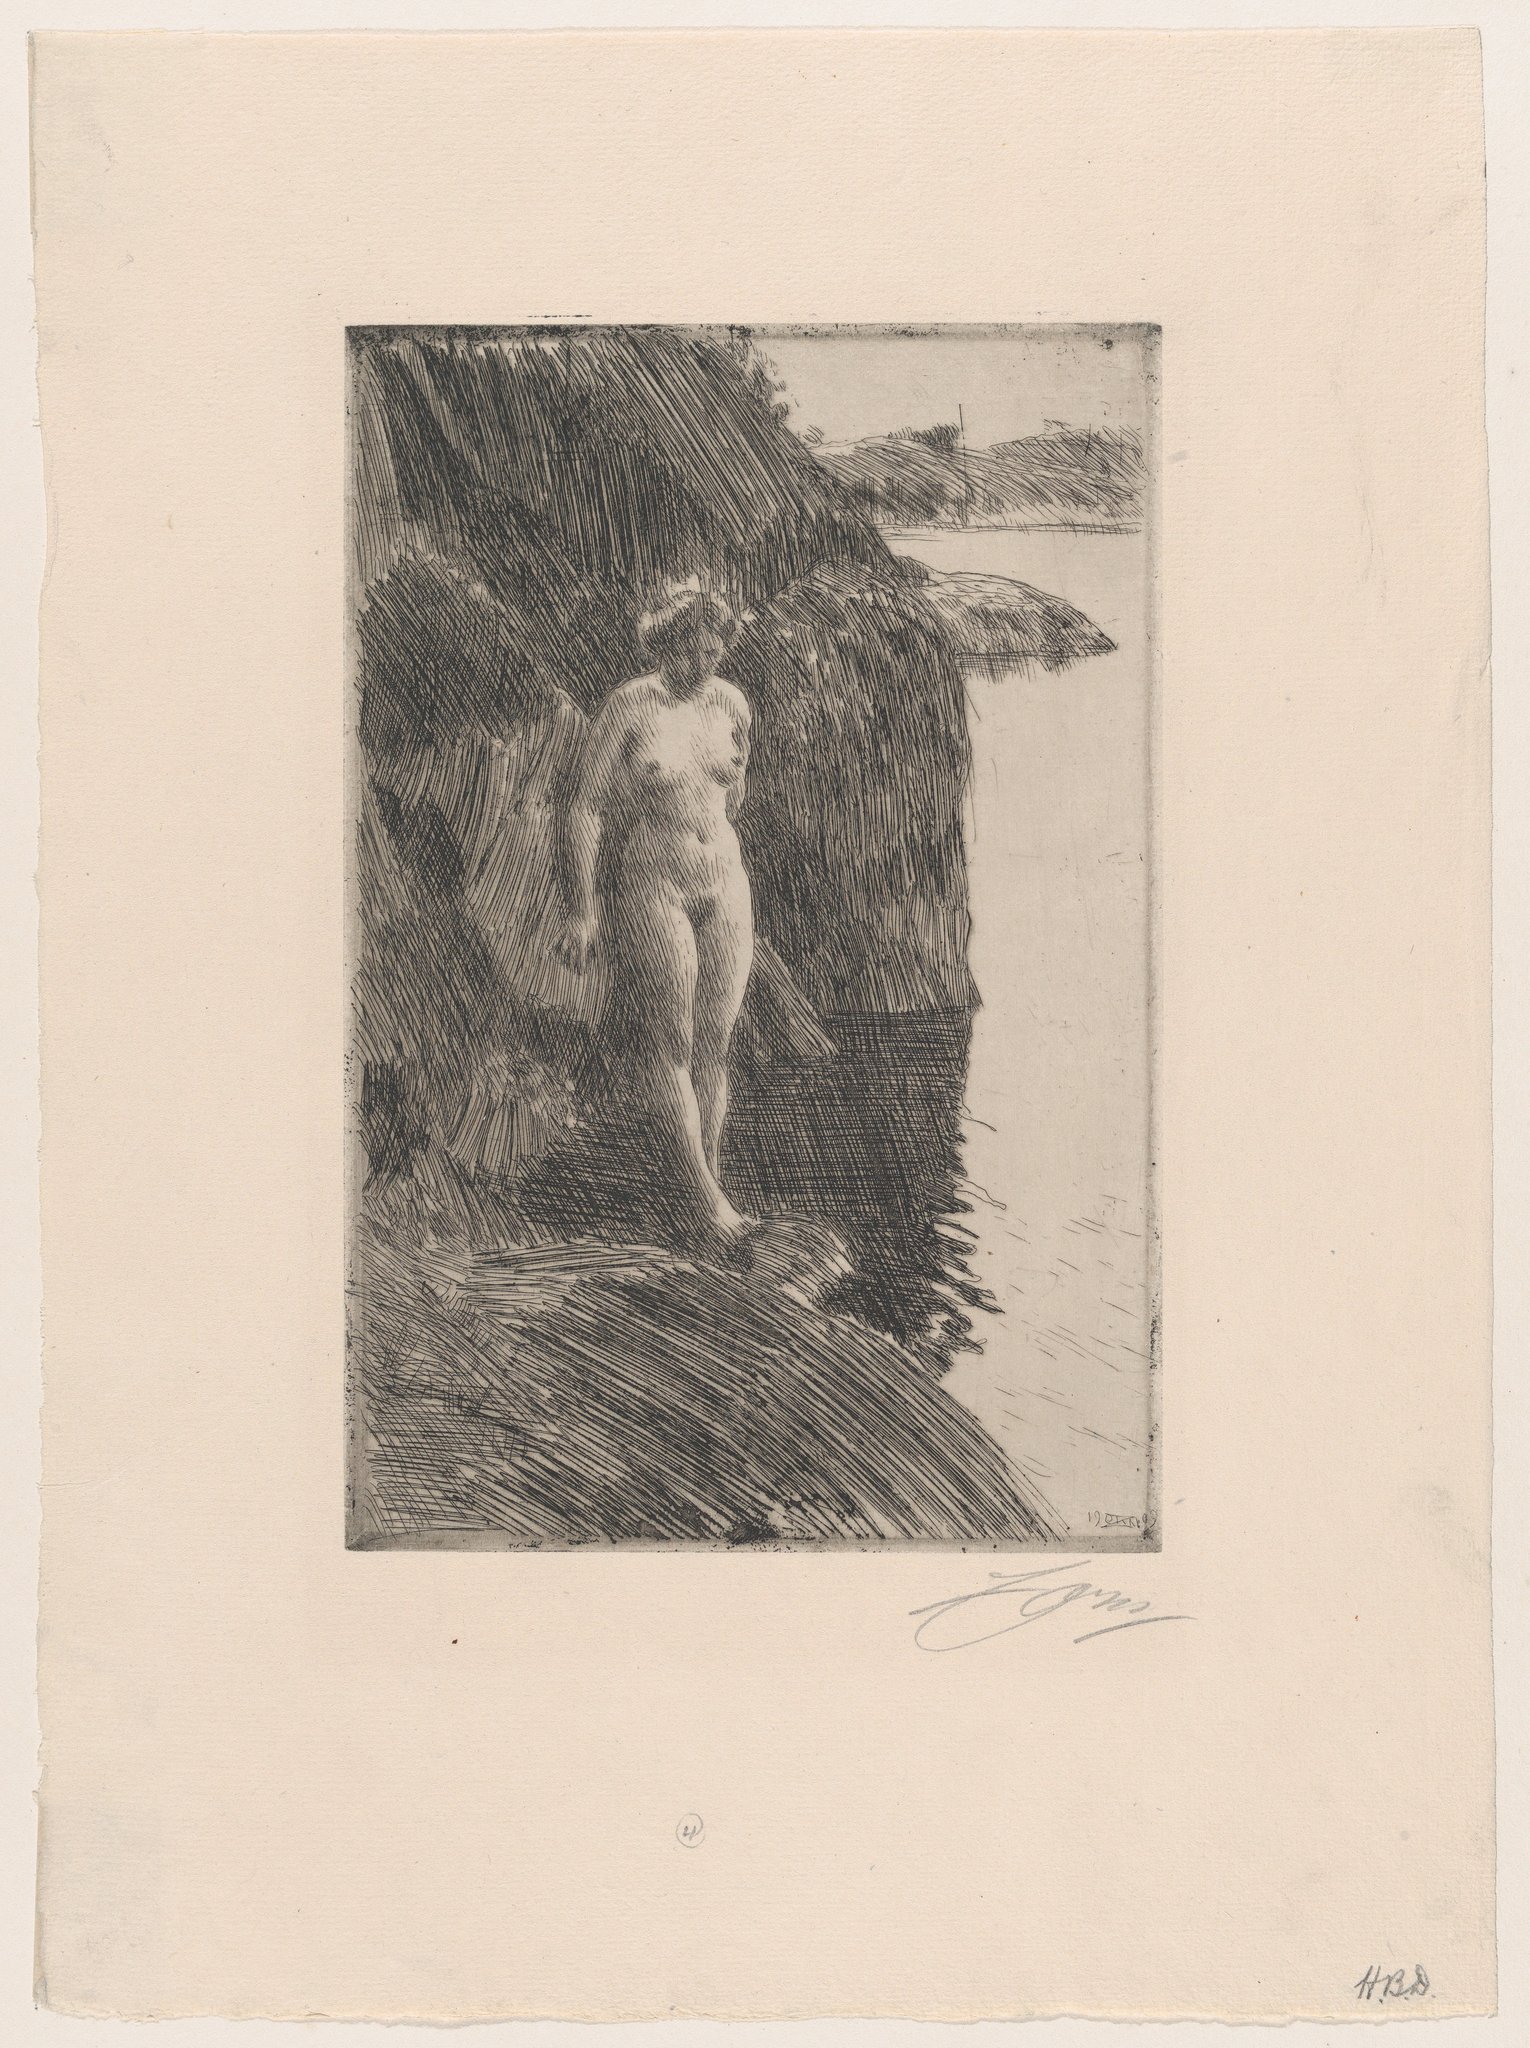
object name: print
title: Precipice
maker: anders zorn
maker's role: artist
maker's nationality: swedish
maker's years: 1860-1920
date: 1909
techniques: etching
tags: female nudes